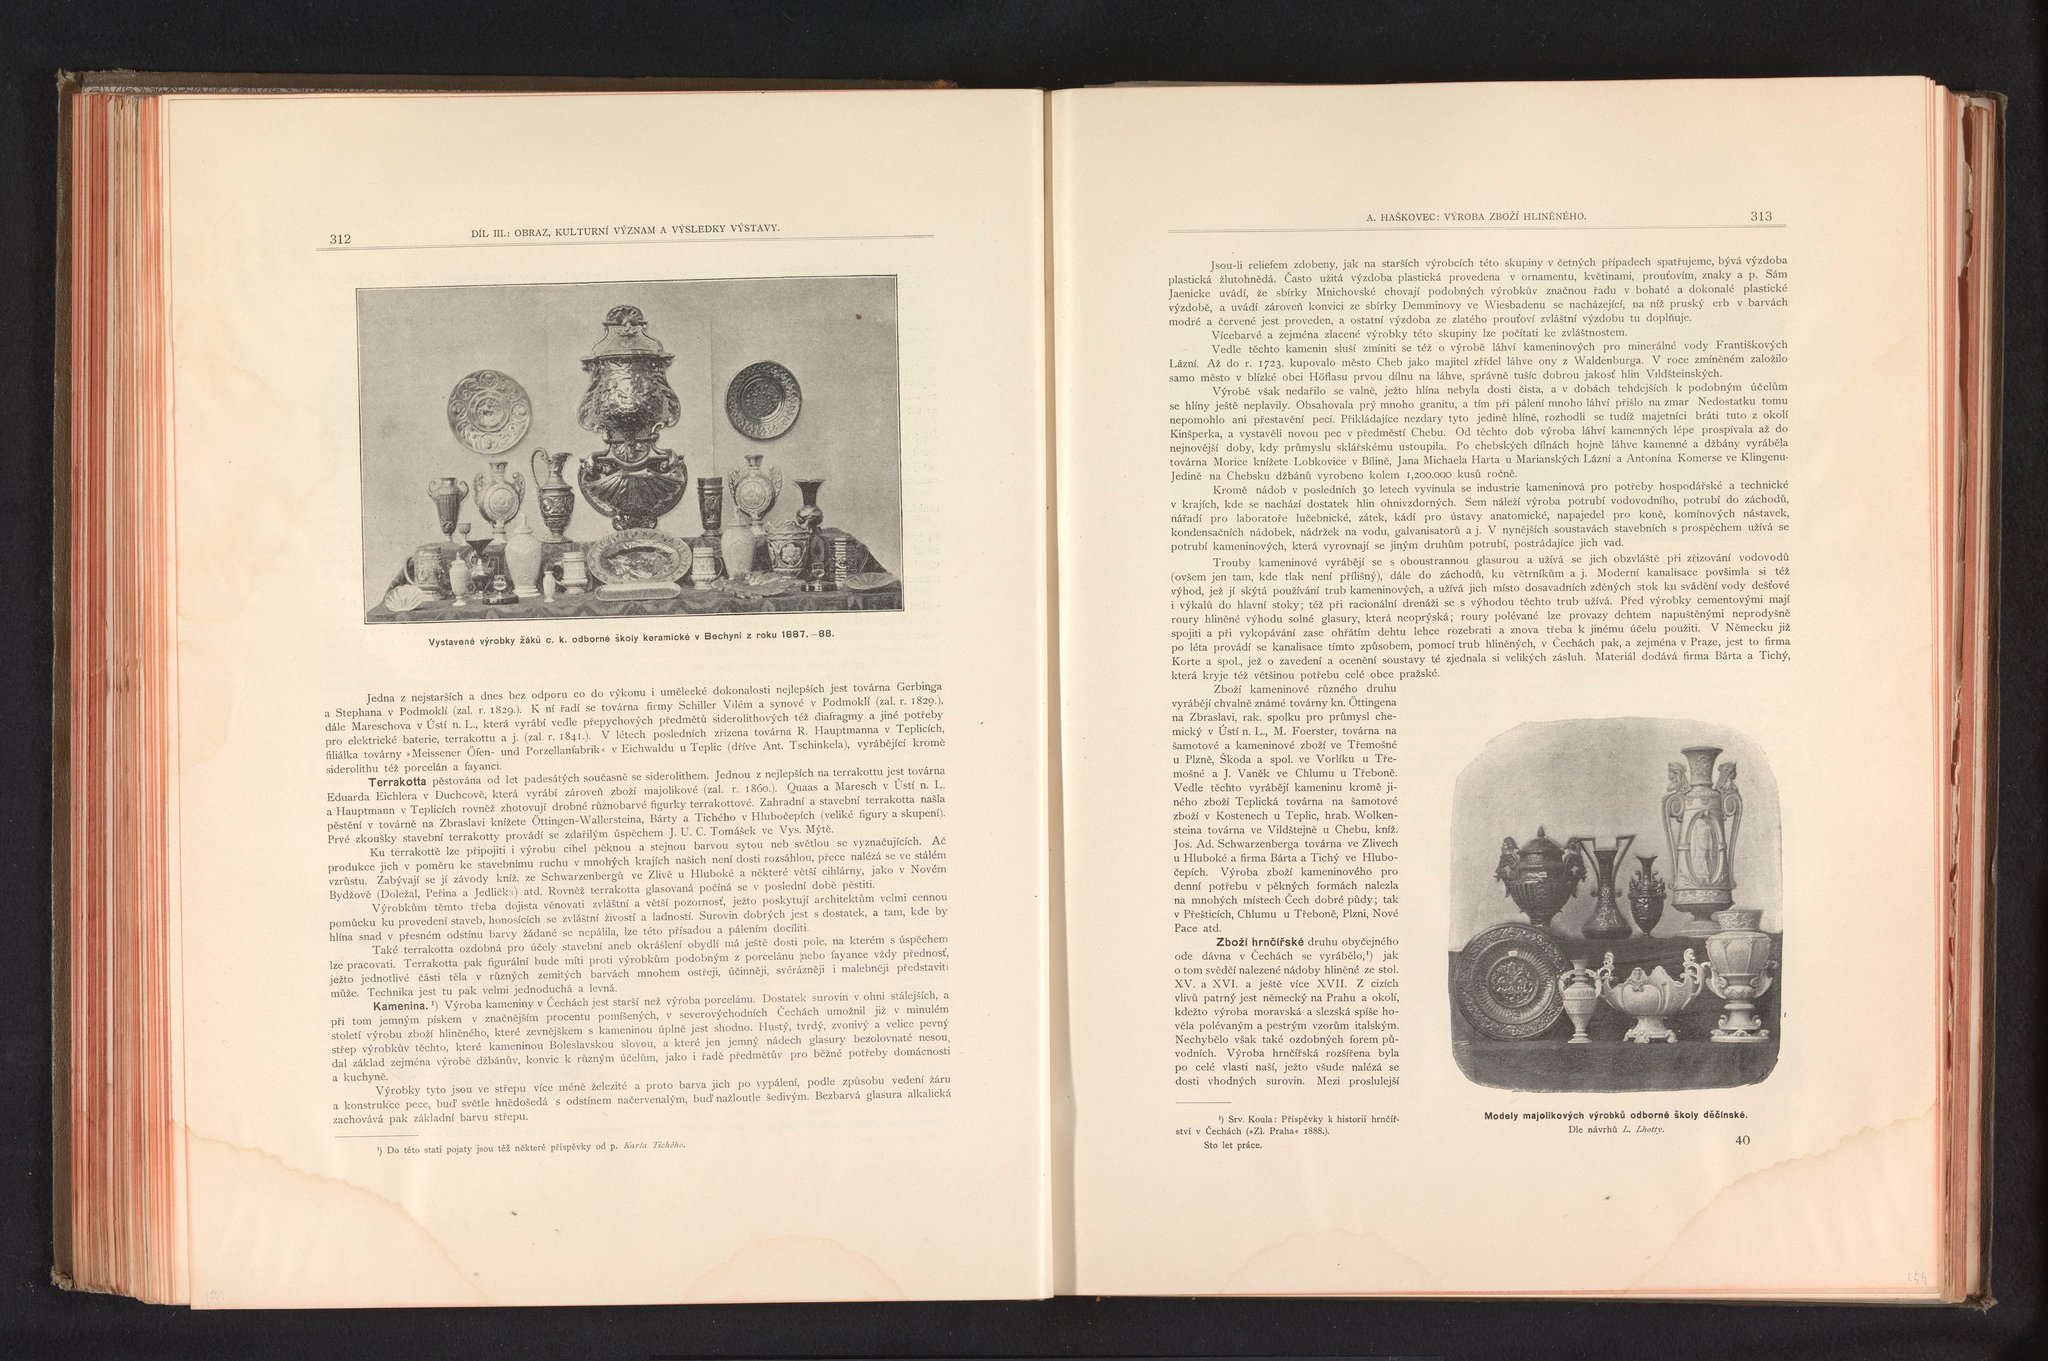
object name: page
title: Opstelling van producten van de School voor Keramiek te Bechyně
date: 1890-1895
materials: paper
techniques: autotype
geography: prague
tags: container of ceramics: jar, jug, pot, vase